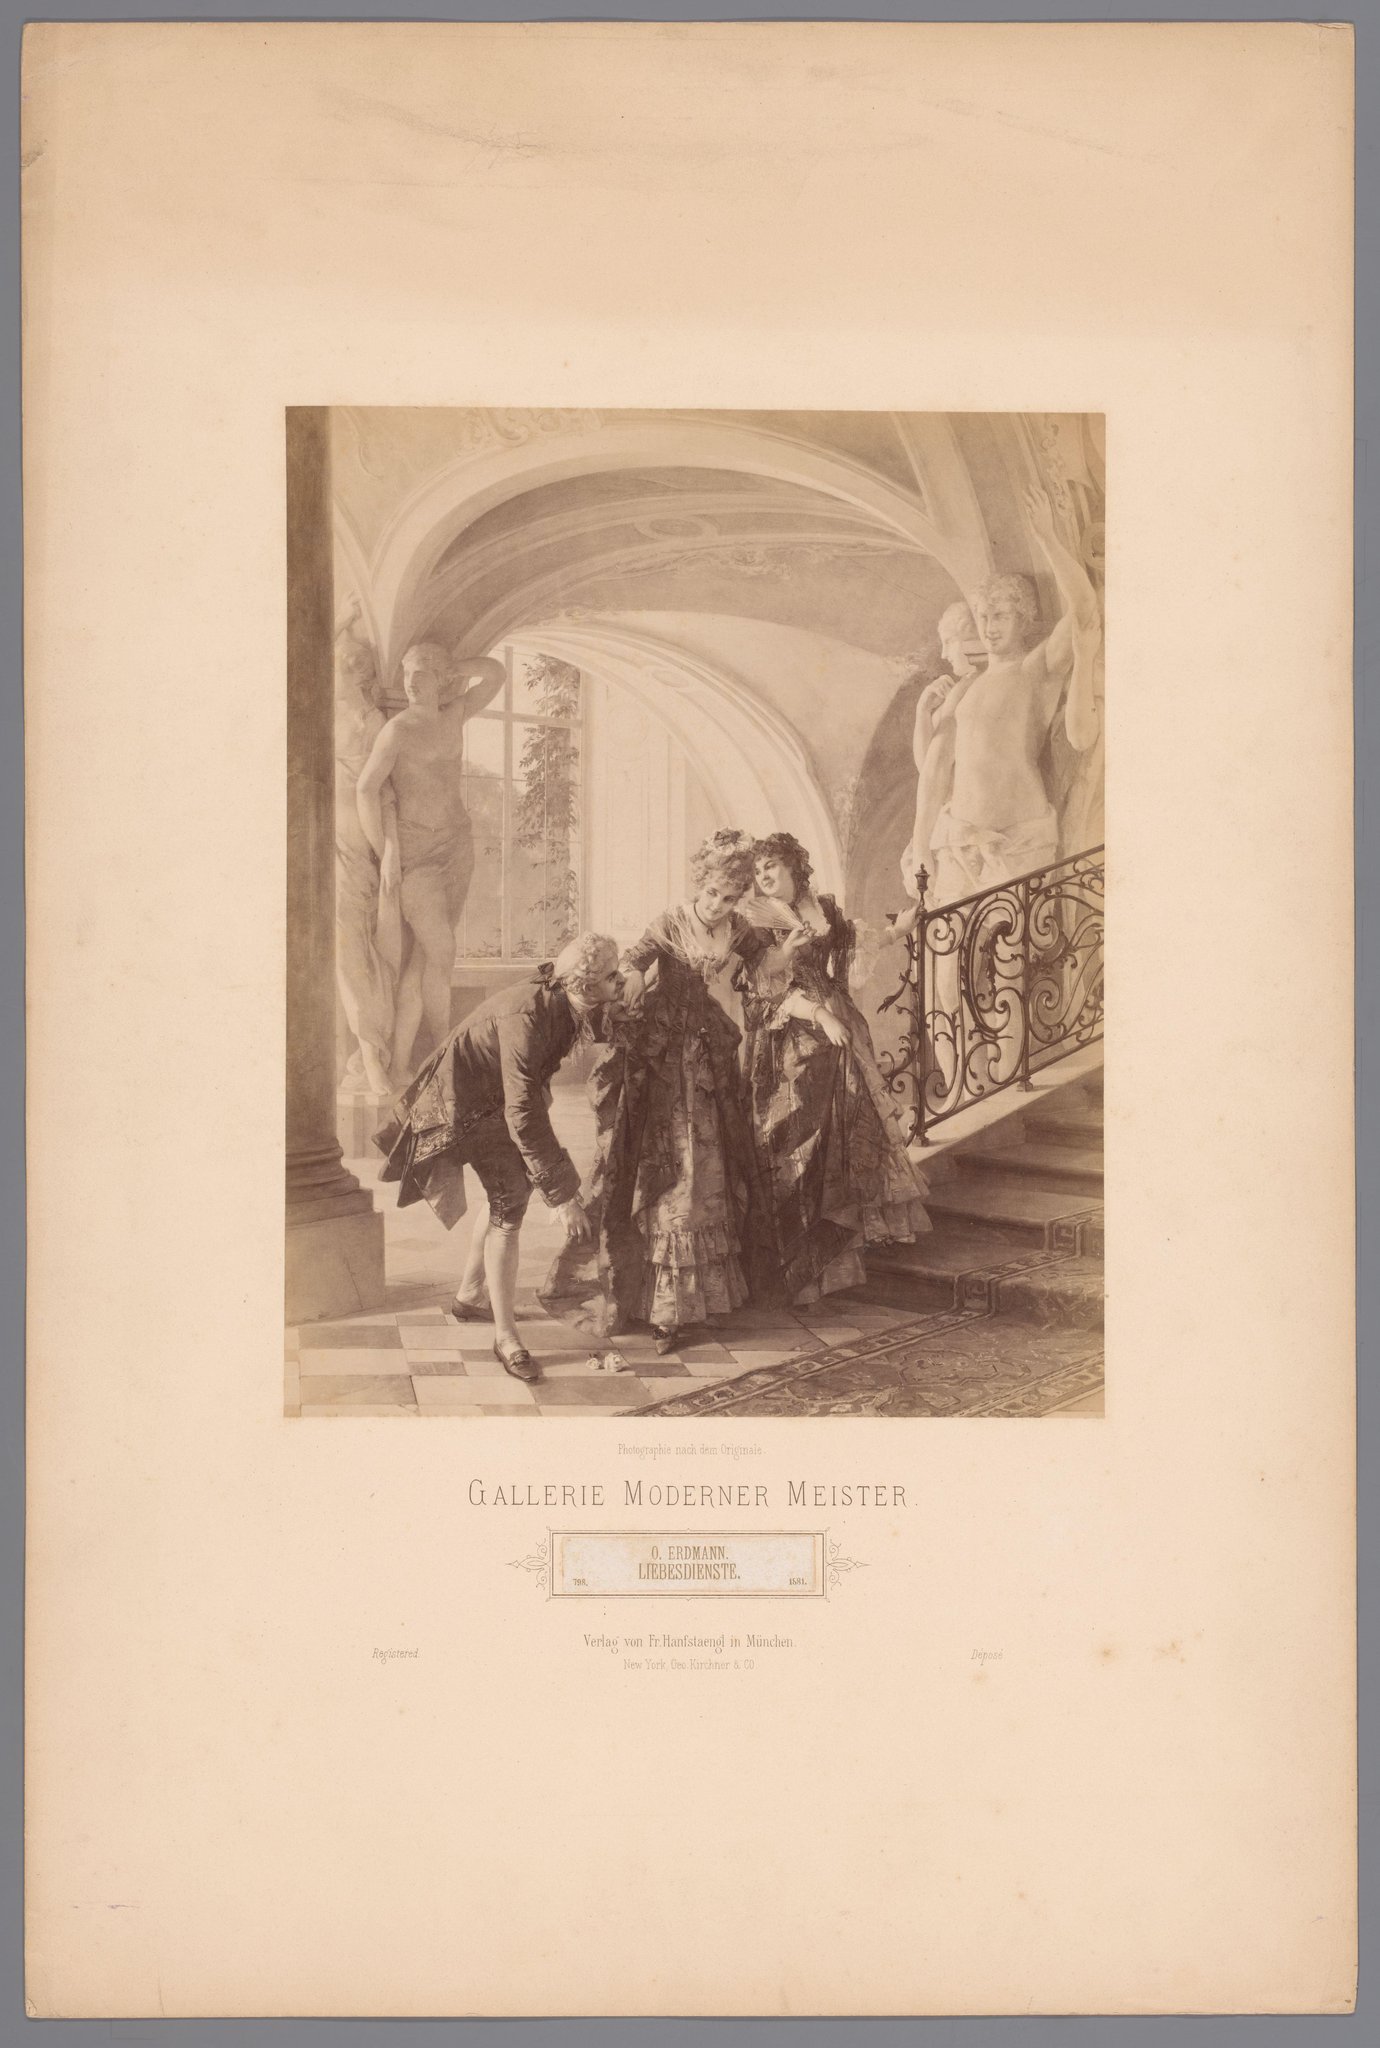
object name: photograph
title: Reproductie van schilderij "Liebesdienste" van Otto Erdmann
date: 1881-1900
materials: cardboard, paper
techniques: albumen print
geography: munich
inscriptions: caption: ‘Photographie nach dem Originale.//GALLERIE MODERNER MEISTER//O. ERDMANN//LIEBESDIENSTE.//798.//1881//Verlag von Fr. Hanfstaengl in München//New York, Geo Kirchner & Co..//Registered//Déposé’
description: Genretafereel twee vrouwen bij een trap, en een man die een van de vrouwen een handkus geeft. Op de achtergrond arcaden van een gebouw, gedragen door grote marmeren beelden.